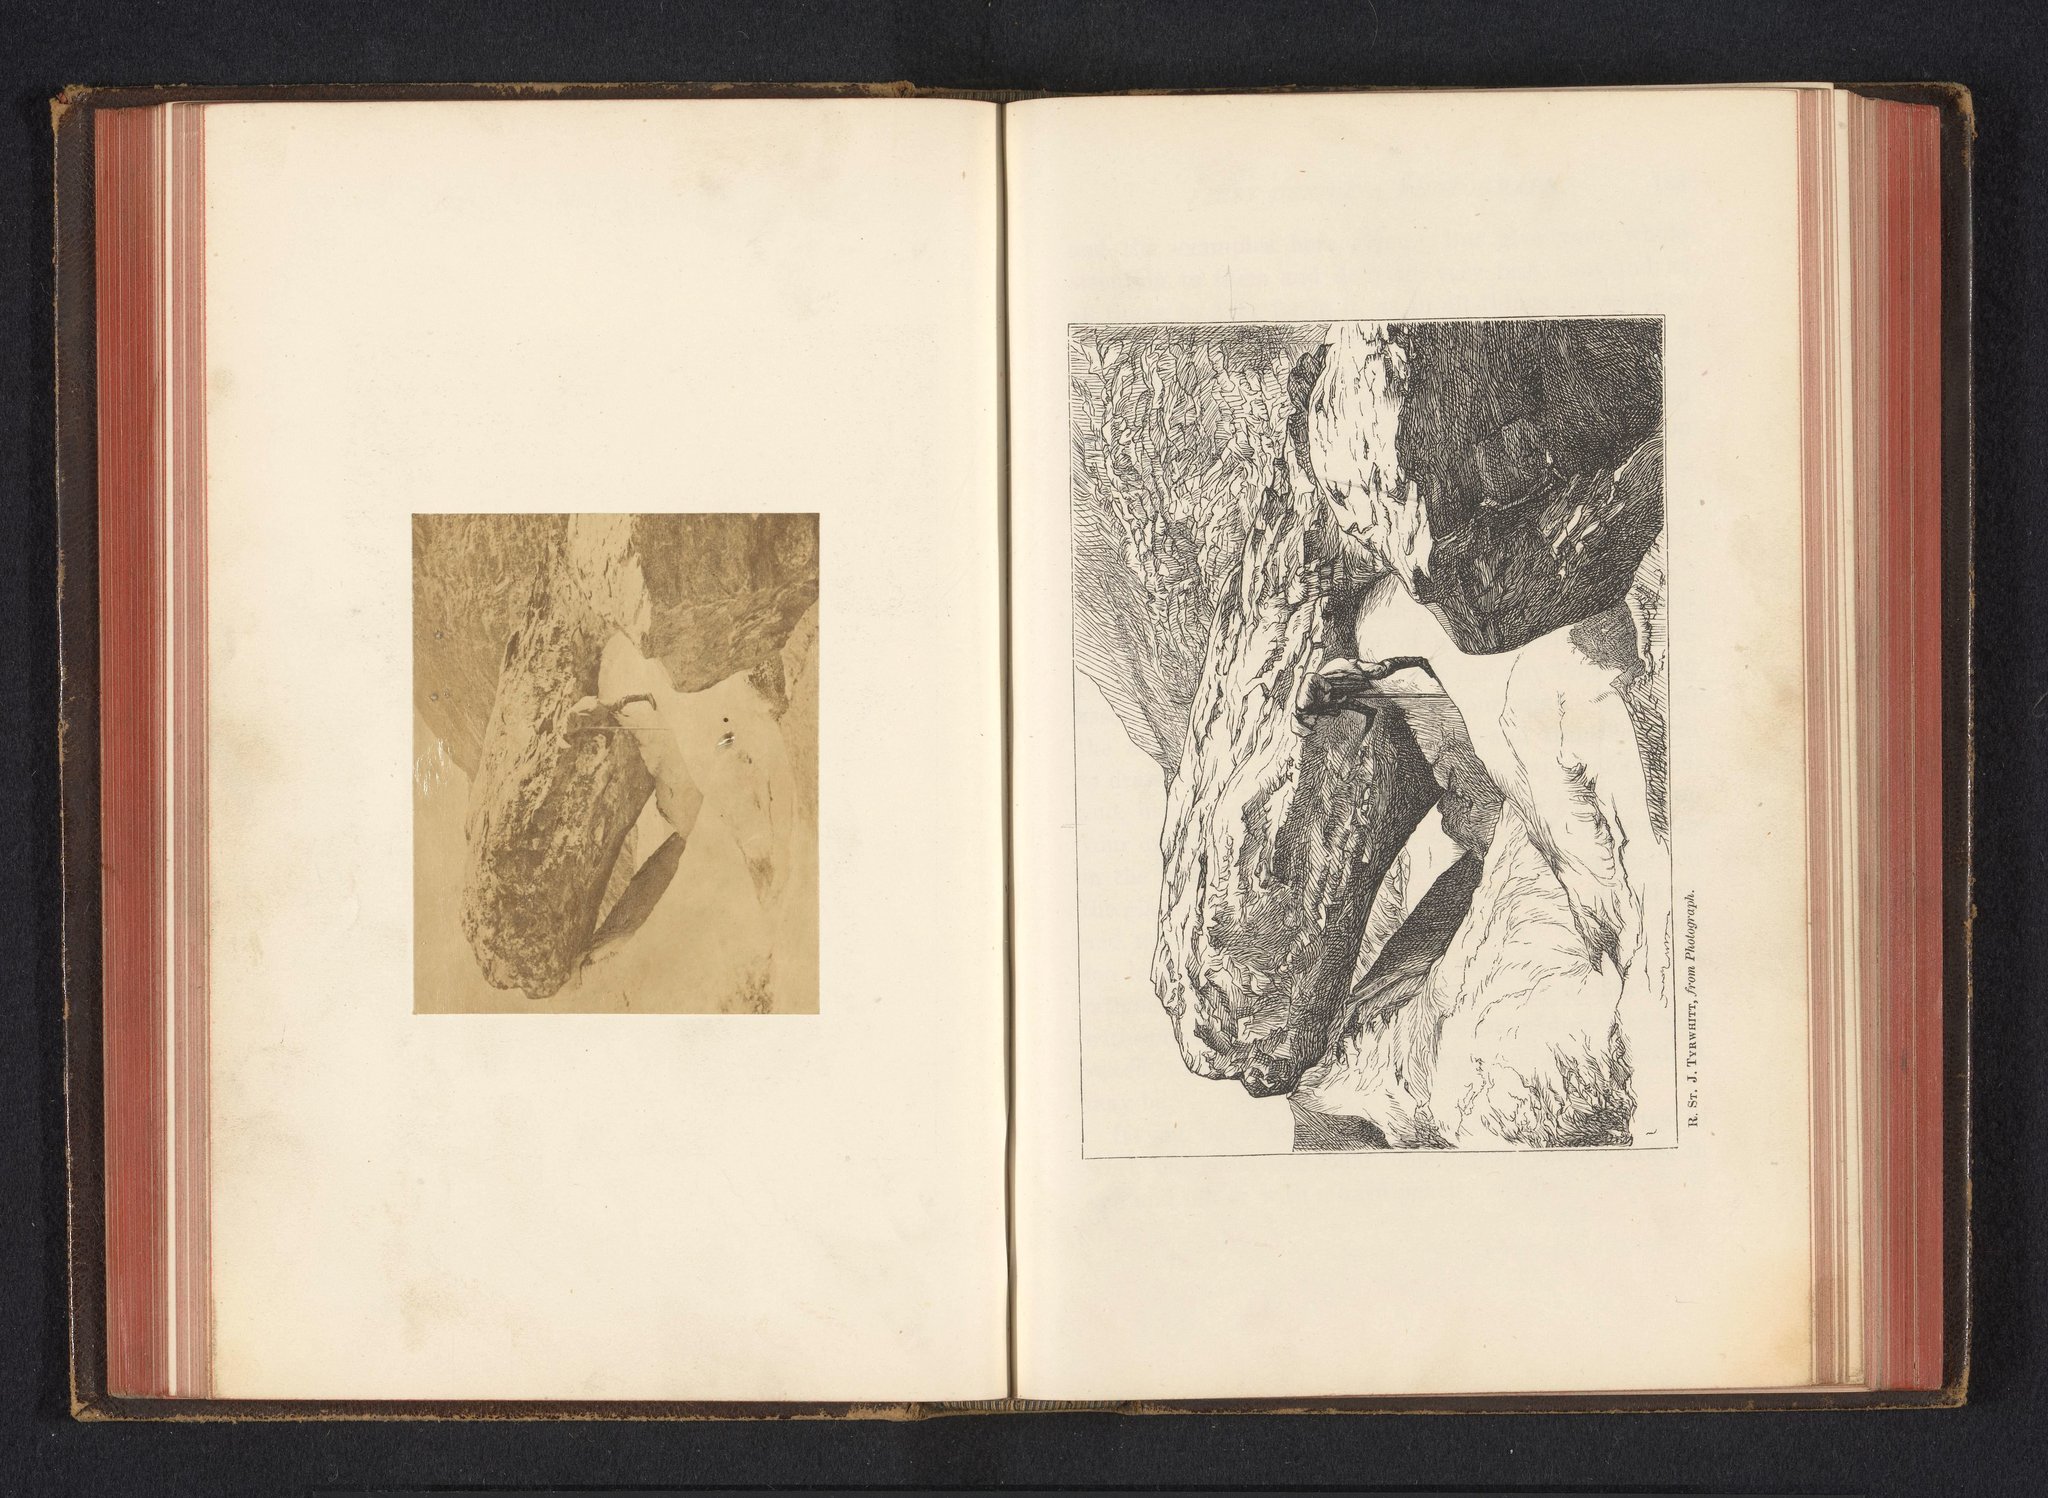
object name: page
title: Bergbeklimmer voor een rots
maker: Anonymous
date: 1858-1868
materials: photographic support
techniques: albumen print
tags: mountain climbing, mountaineering, walking, hiking (recreation), rock-formations